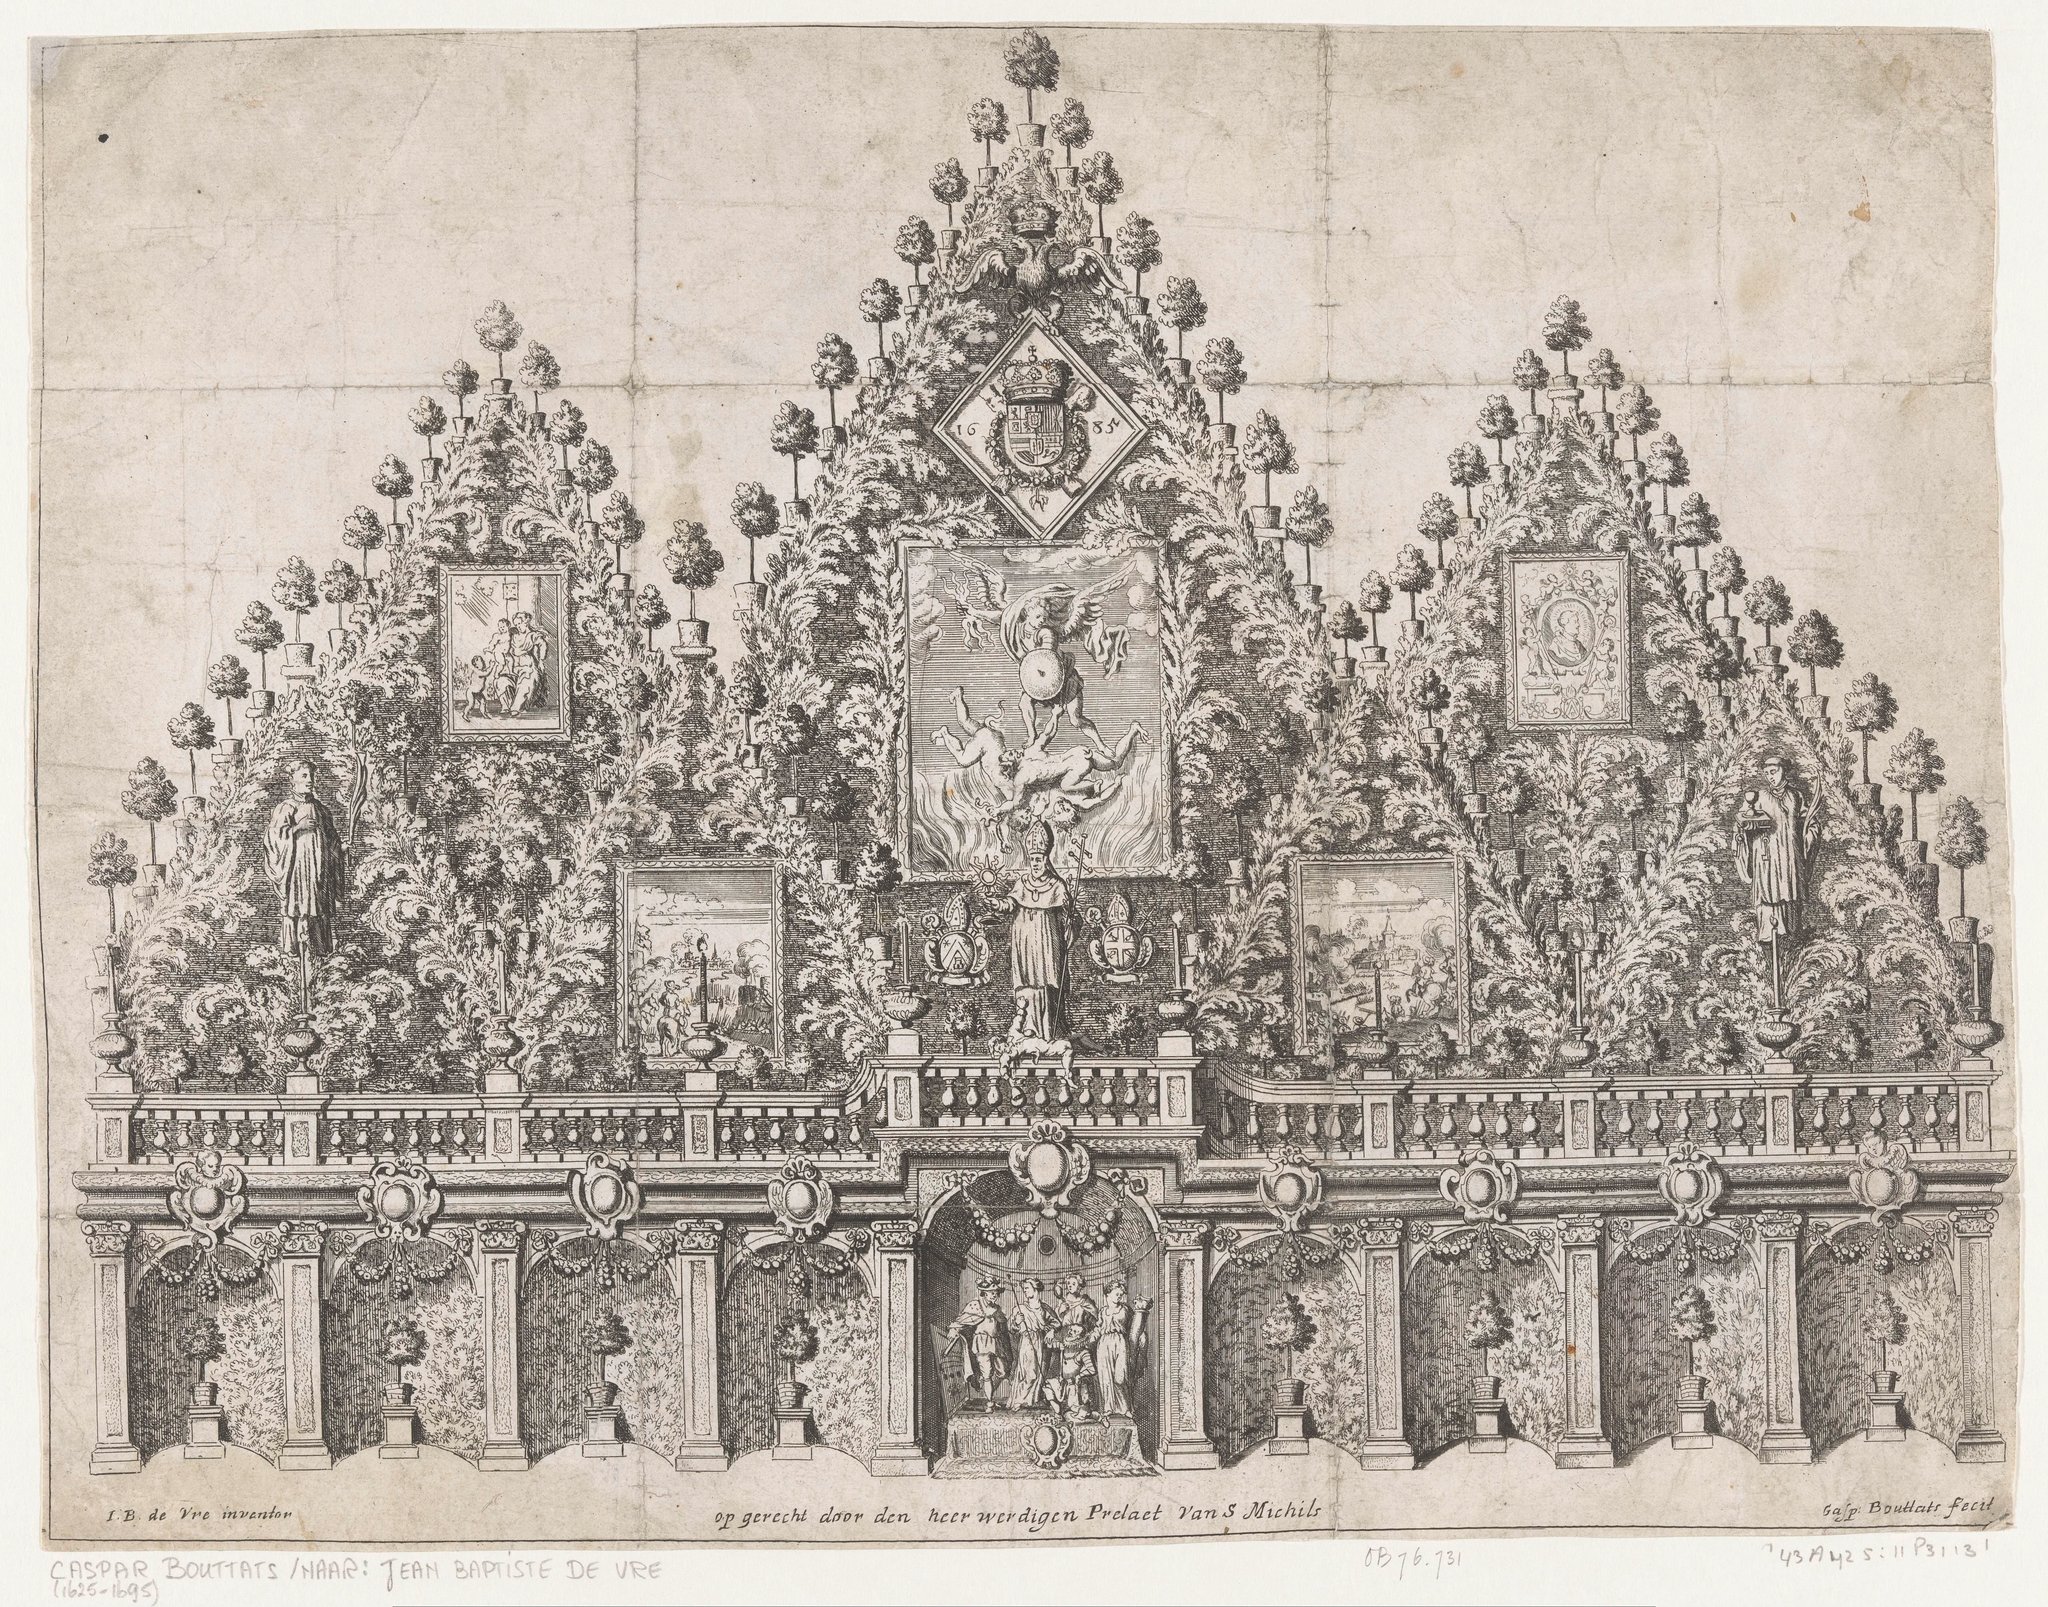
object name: print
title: Arcade opgericht voor de Sint-Michielsabdij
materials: paper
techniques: etching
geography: antwerp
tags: triumphal arch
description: Arcade opgericht te Antwerpen voor de Sint-Michielsabdij. Arcade met negen nissen waarboven een balustrade met drie piramides en vijf schilderijen. Onderdeel van de illustraties van de versieringen opgericht te Antwerpen bij de viering in 1685 van het eeuwfeest van de bevrijding van de stad door de hertog van Parma in 1585.